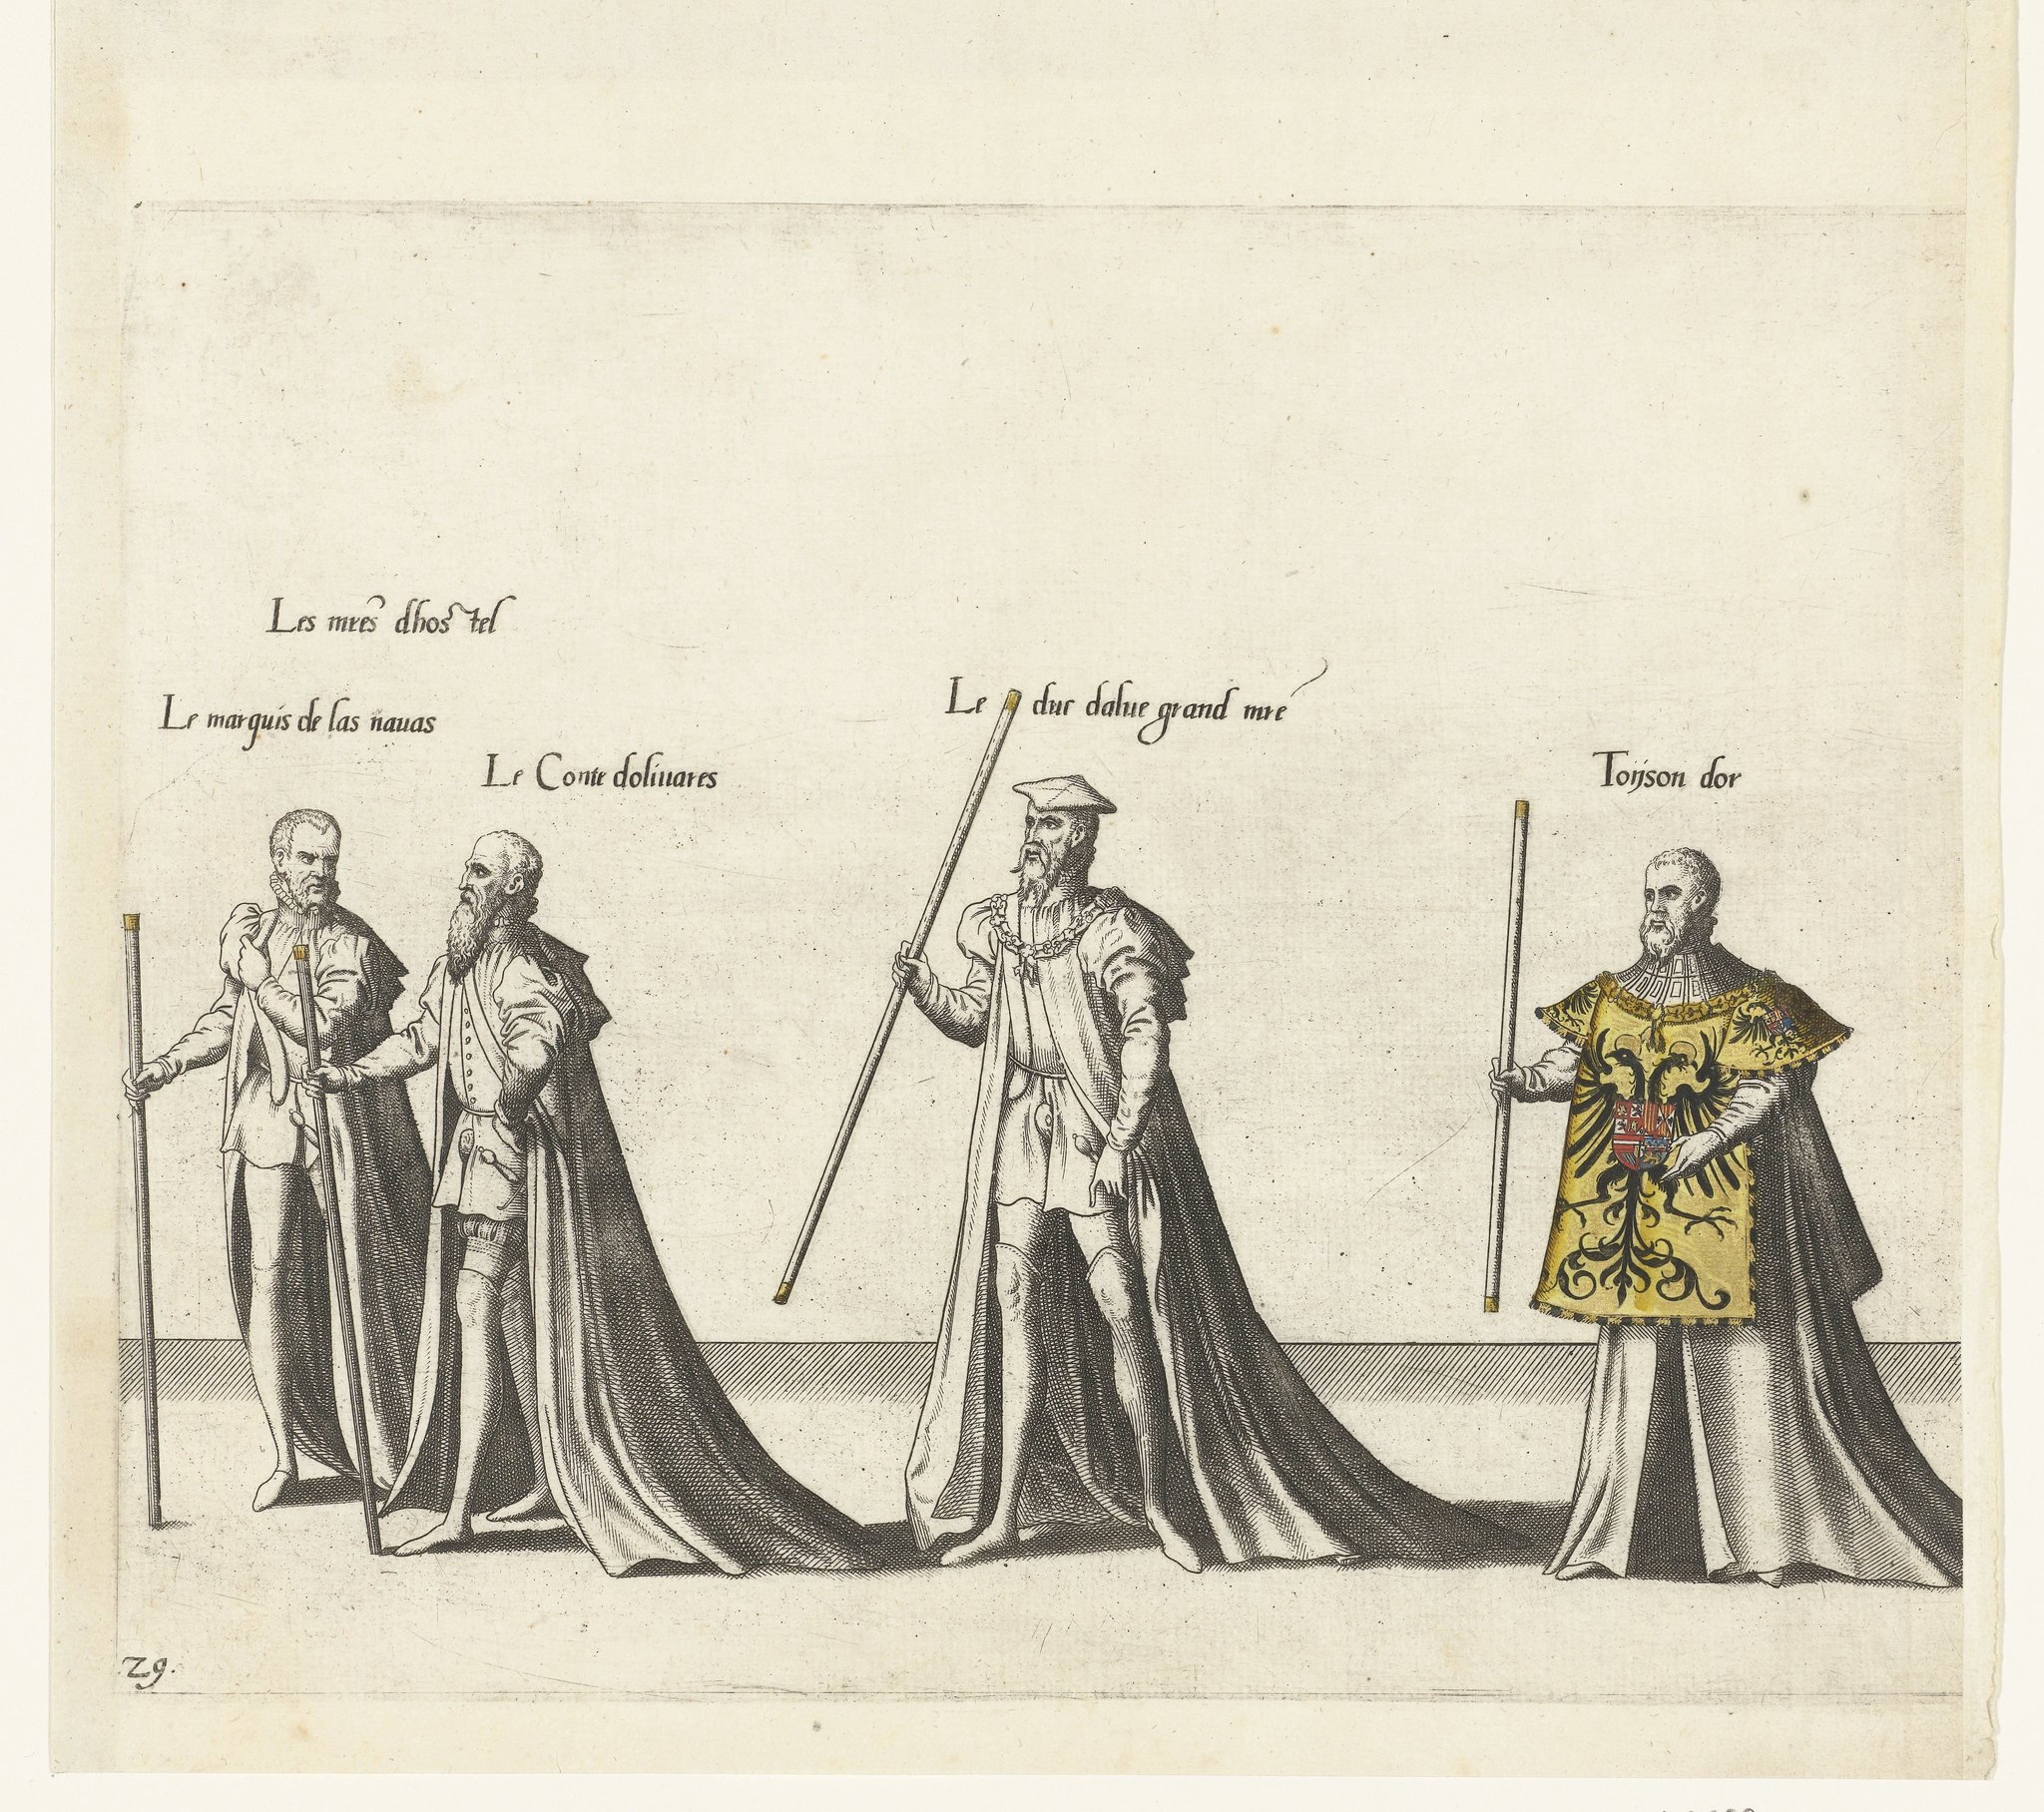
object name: print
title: Begrafenisoptocht van keizer Karel V, 1558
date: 1559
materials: paper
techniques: engraving, etching, hand coloring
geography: southern netherlands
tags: fernando álvarez de toledo (3rd duke of alba), ghent, charles v (holy roman emperor and king of spain), cortege, funeral procession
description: Vier edelen die deelnemen aan de optocht, waaronder de hertog van Alva. Onderdeel van de prentreeks van de Begrafenisoptocht van keizer Karel V op 29 december 1558 te Brussel. Rechts is een strook met één persoon afgesneden.